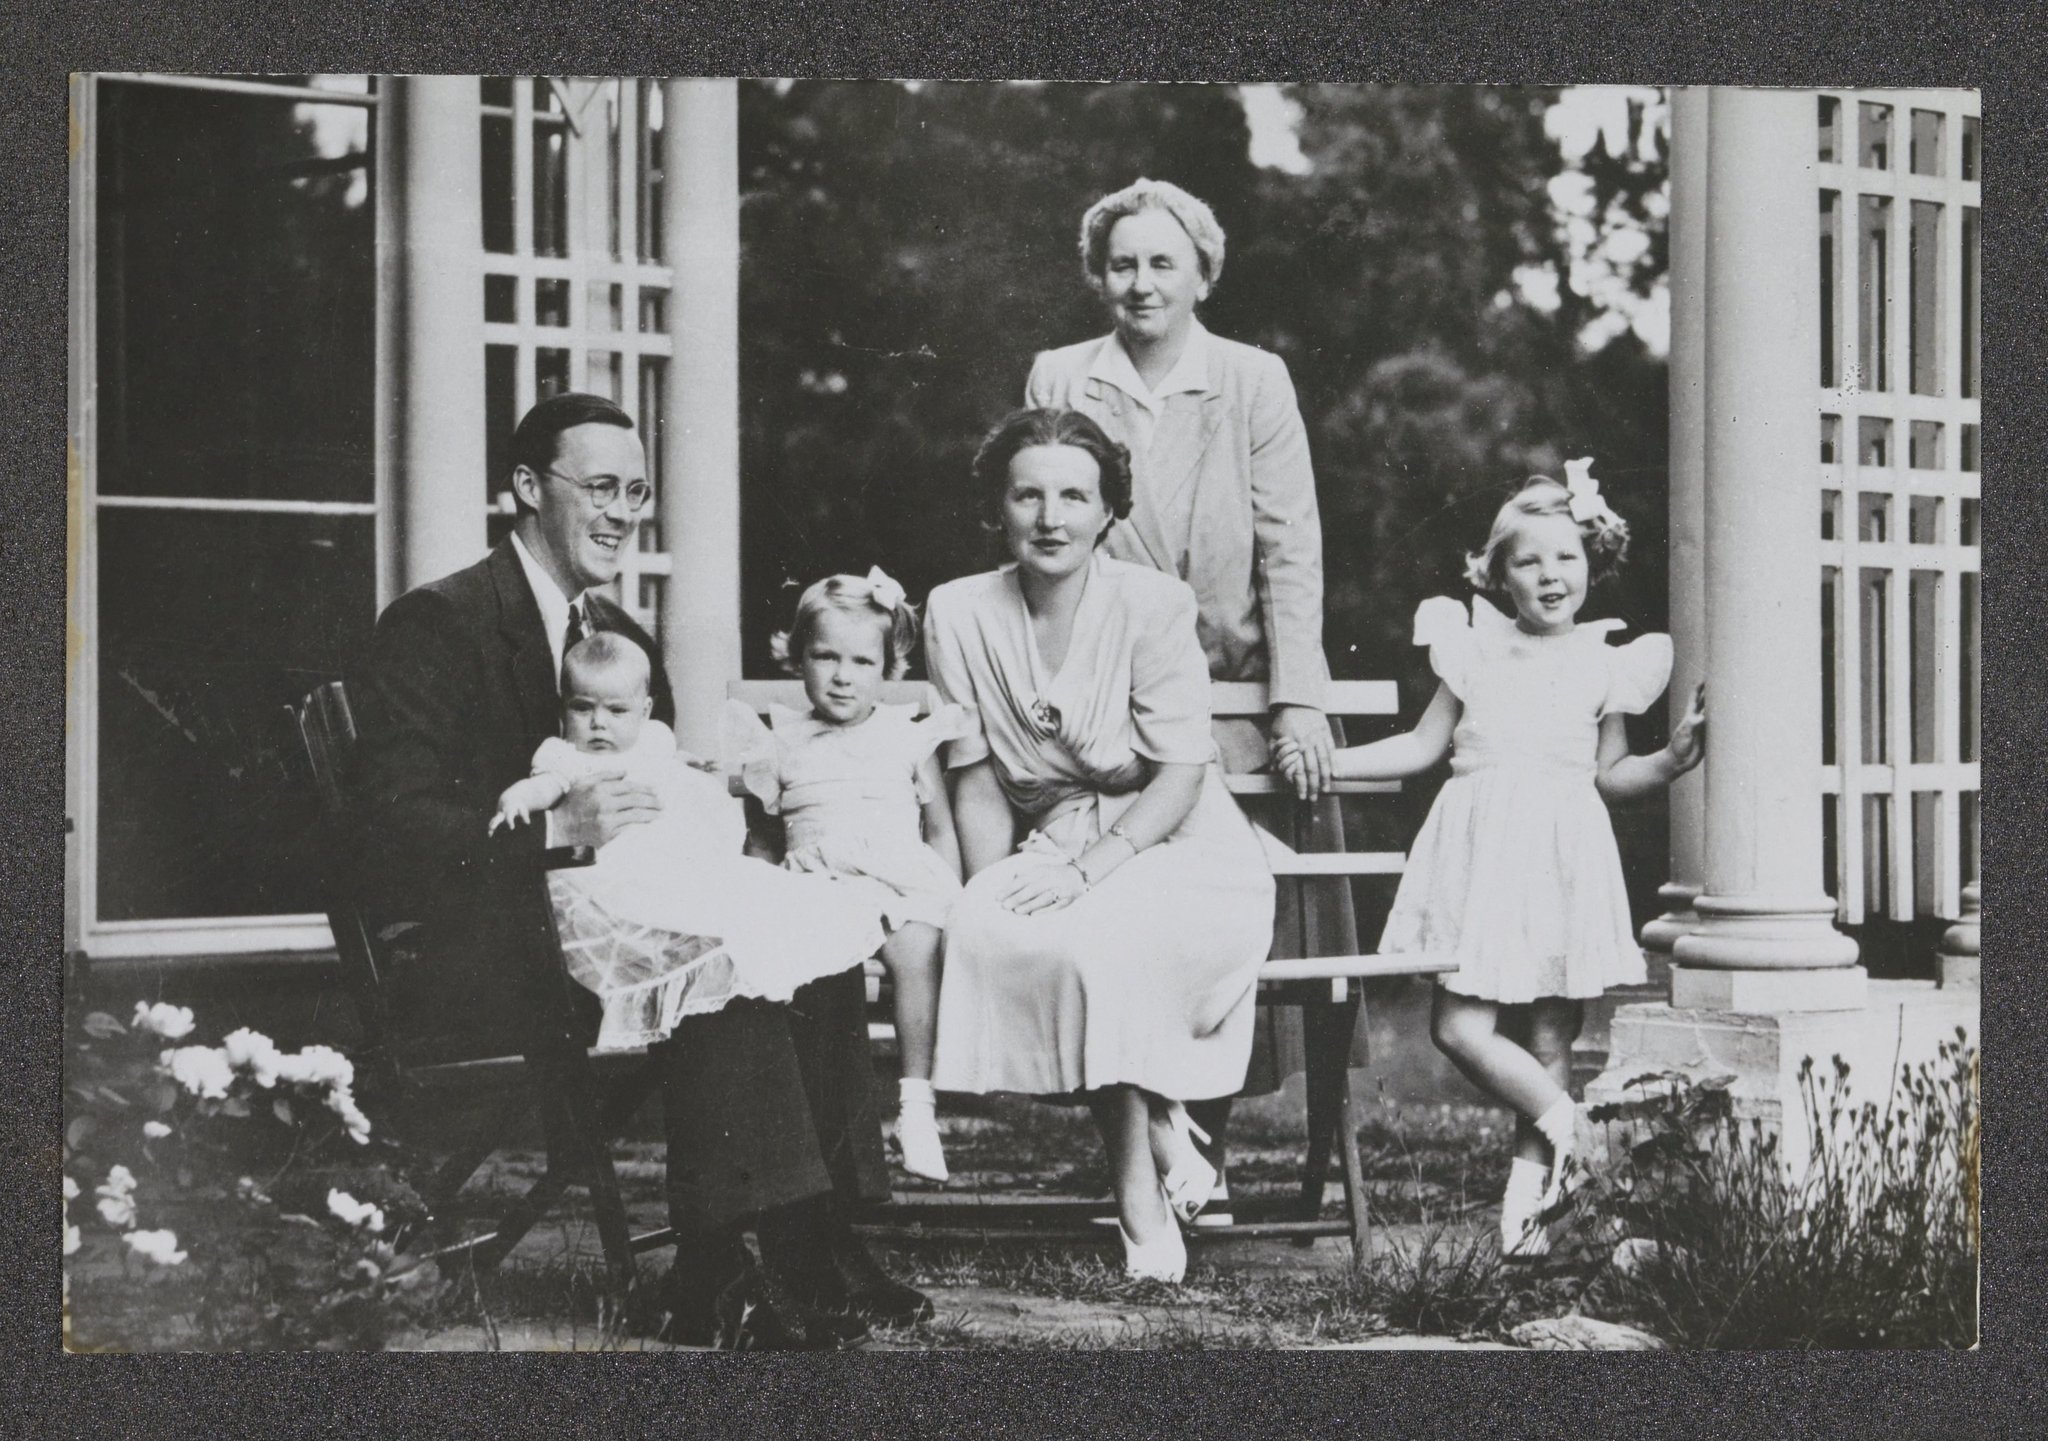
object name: photograph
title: Familieportret van de koninklijke familie in Ottawa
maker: Anonymous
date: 1910-1943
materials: photographic support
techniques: gelatin silver print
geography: ottawa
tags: the hague, print maker, wilhelmina of the netherlands, bernhard (prins der nederlanden), beatrix (koningin der nederlanden), juliana of the netherlands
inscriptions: inscription: ‘Ottawa Zomer 1943’, stamp: ‘copyright ANEFO Kerkstraat 310 PRF 141’